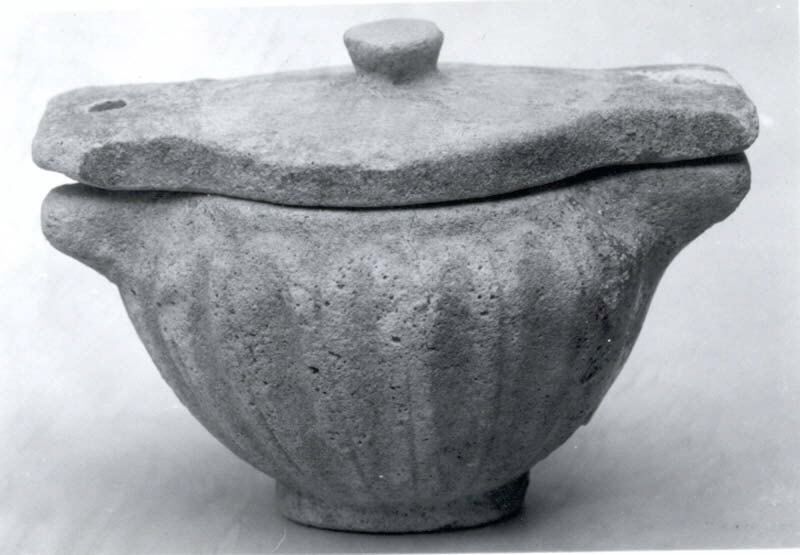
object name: jar with lid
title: Jar lid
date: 1600-1101 BCE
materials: faience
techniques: glazing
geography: mesopotamia